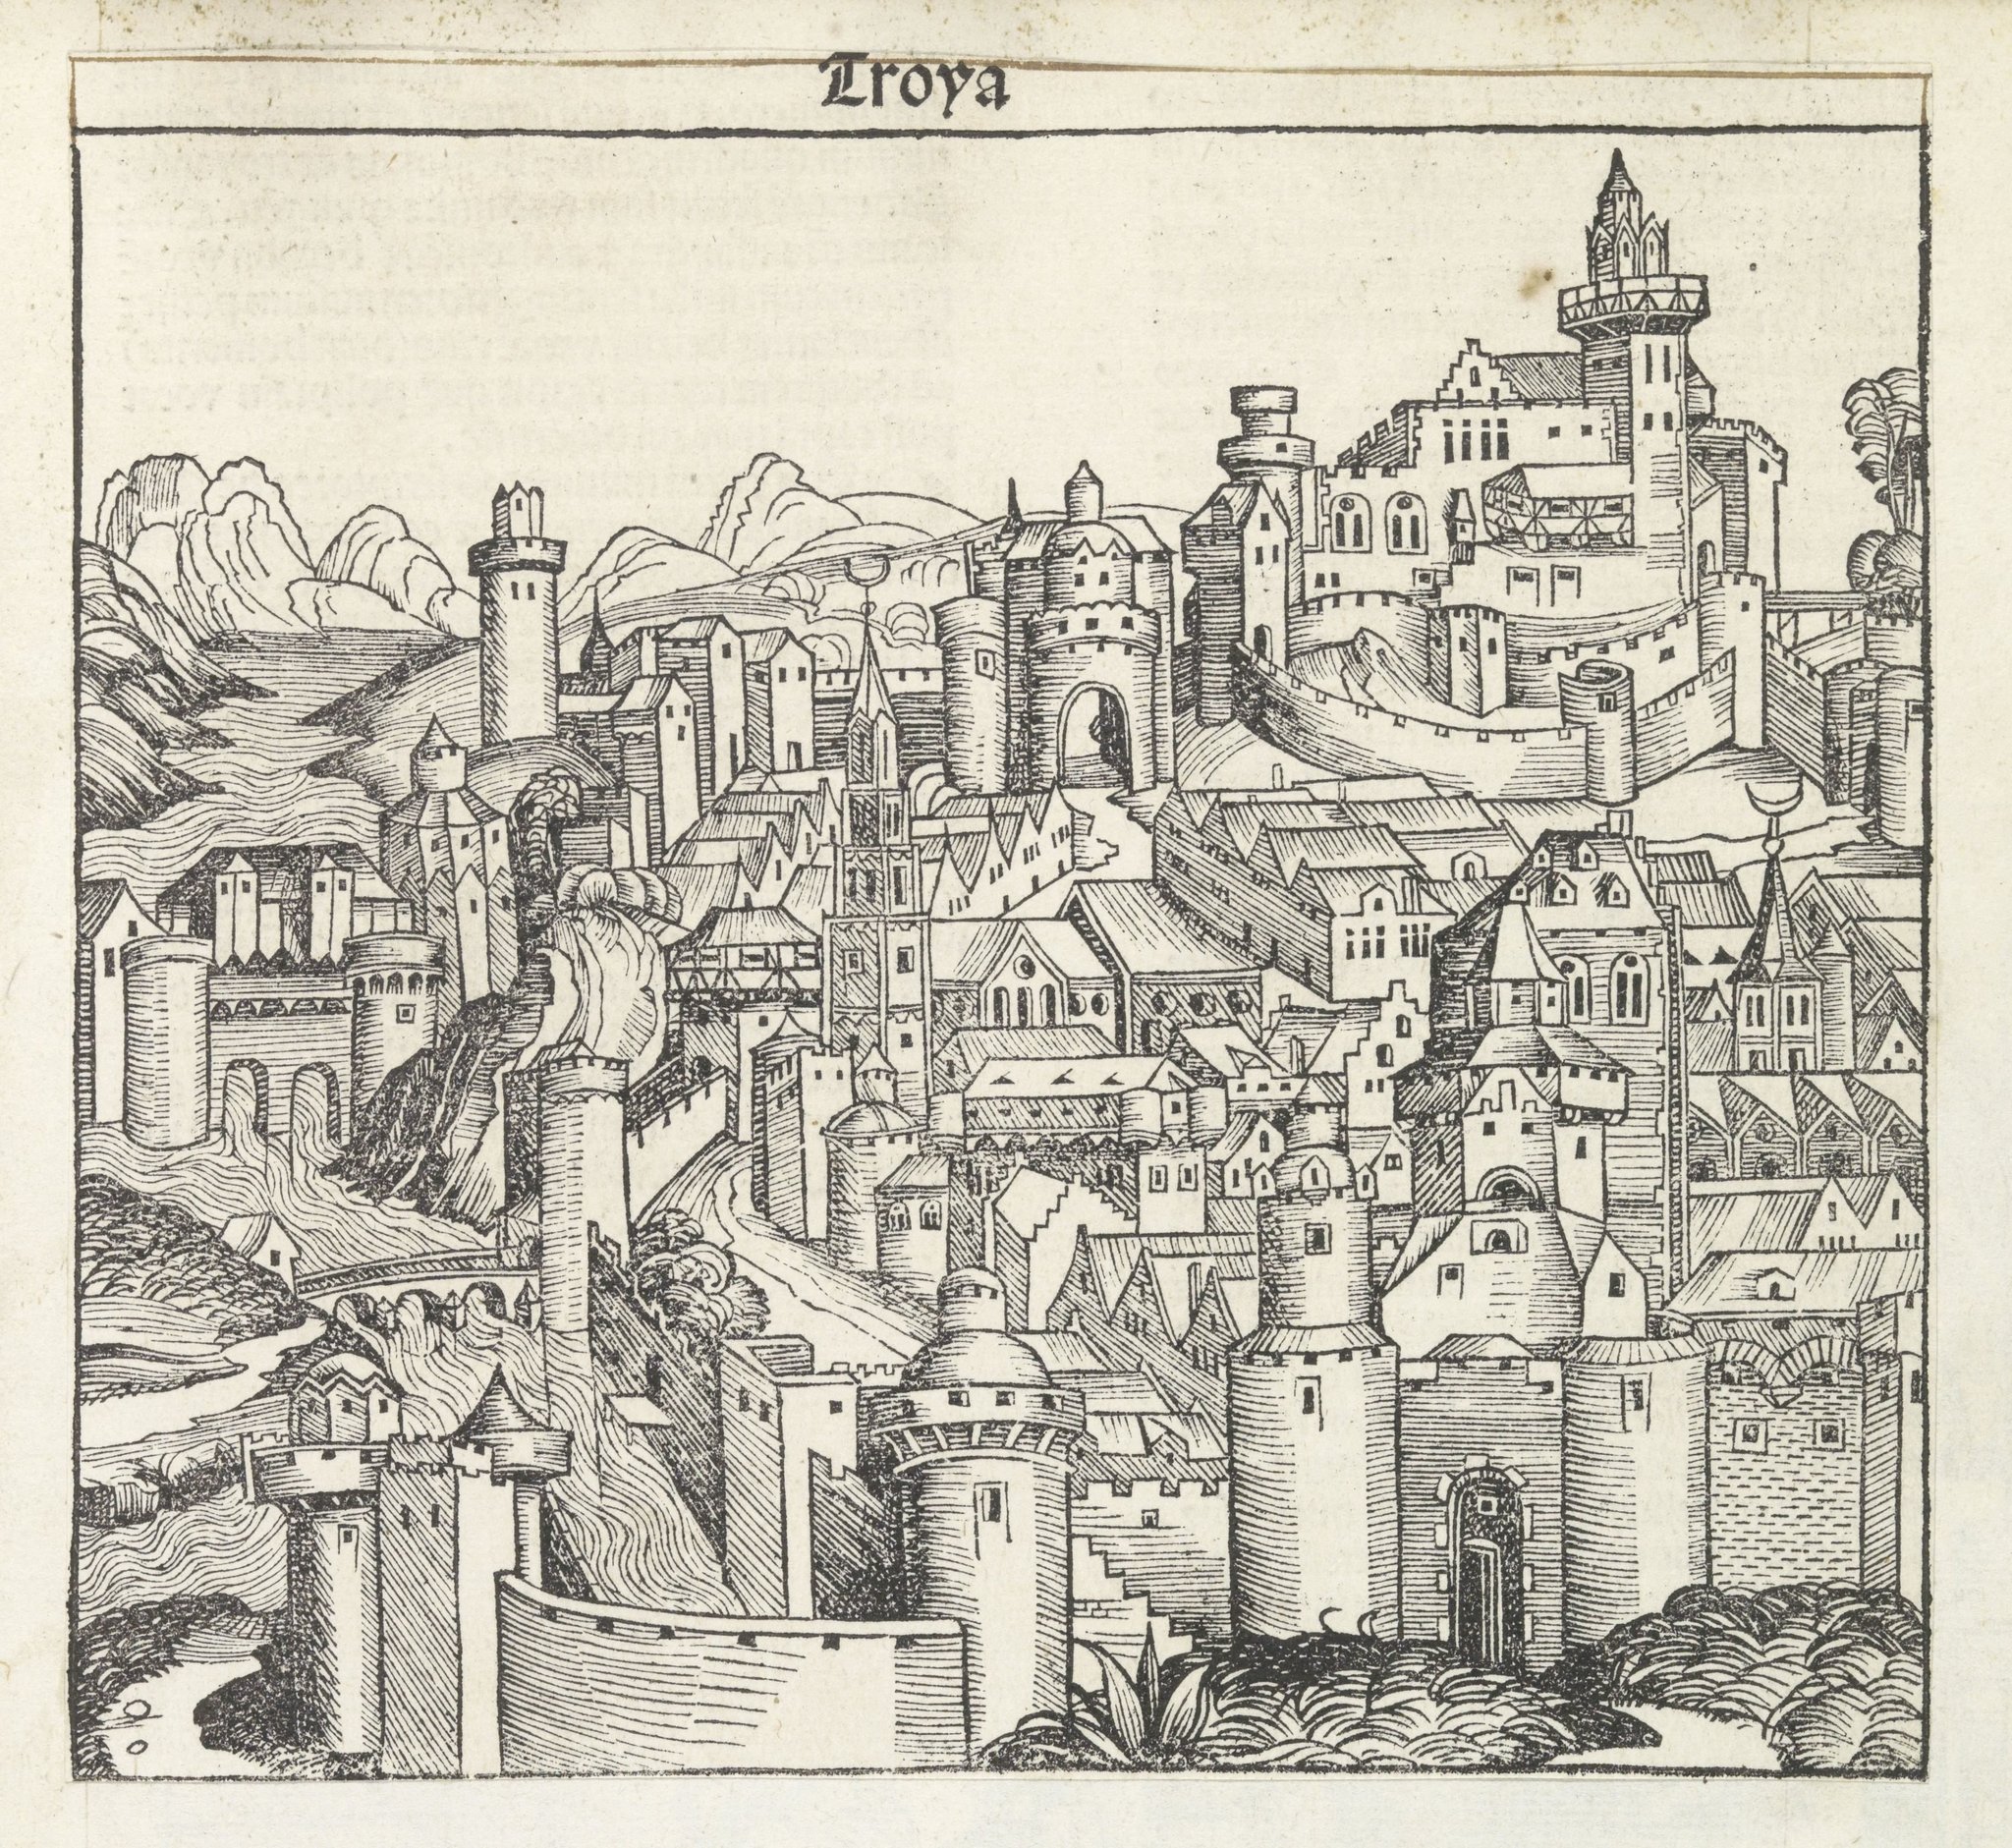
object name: book illustration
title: Gezicht op Troje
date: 1493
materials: paper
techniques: letterpress printing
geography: nuremberg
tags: city-view, and landscape with man-made constructions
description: De houtsnede wordt gebruikt als boekillustratie in de Liber Chronicarum (of Neurenbergkroniek) van Hartmann Schedel, verschenen in het Latijn en Duits in 1493. Zie de Latijnse uitgave, folio 36r.